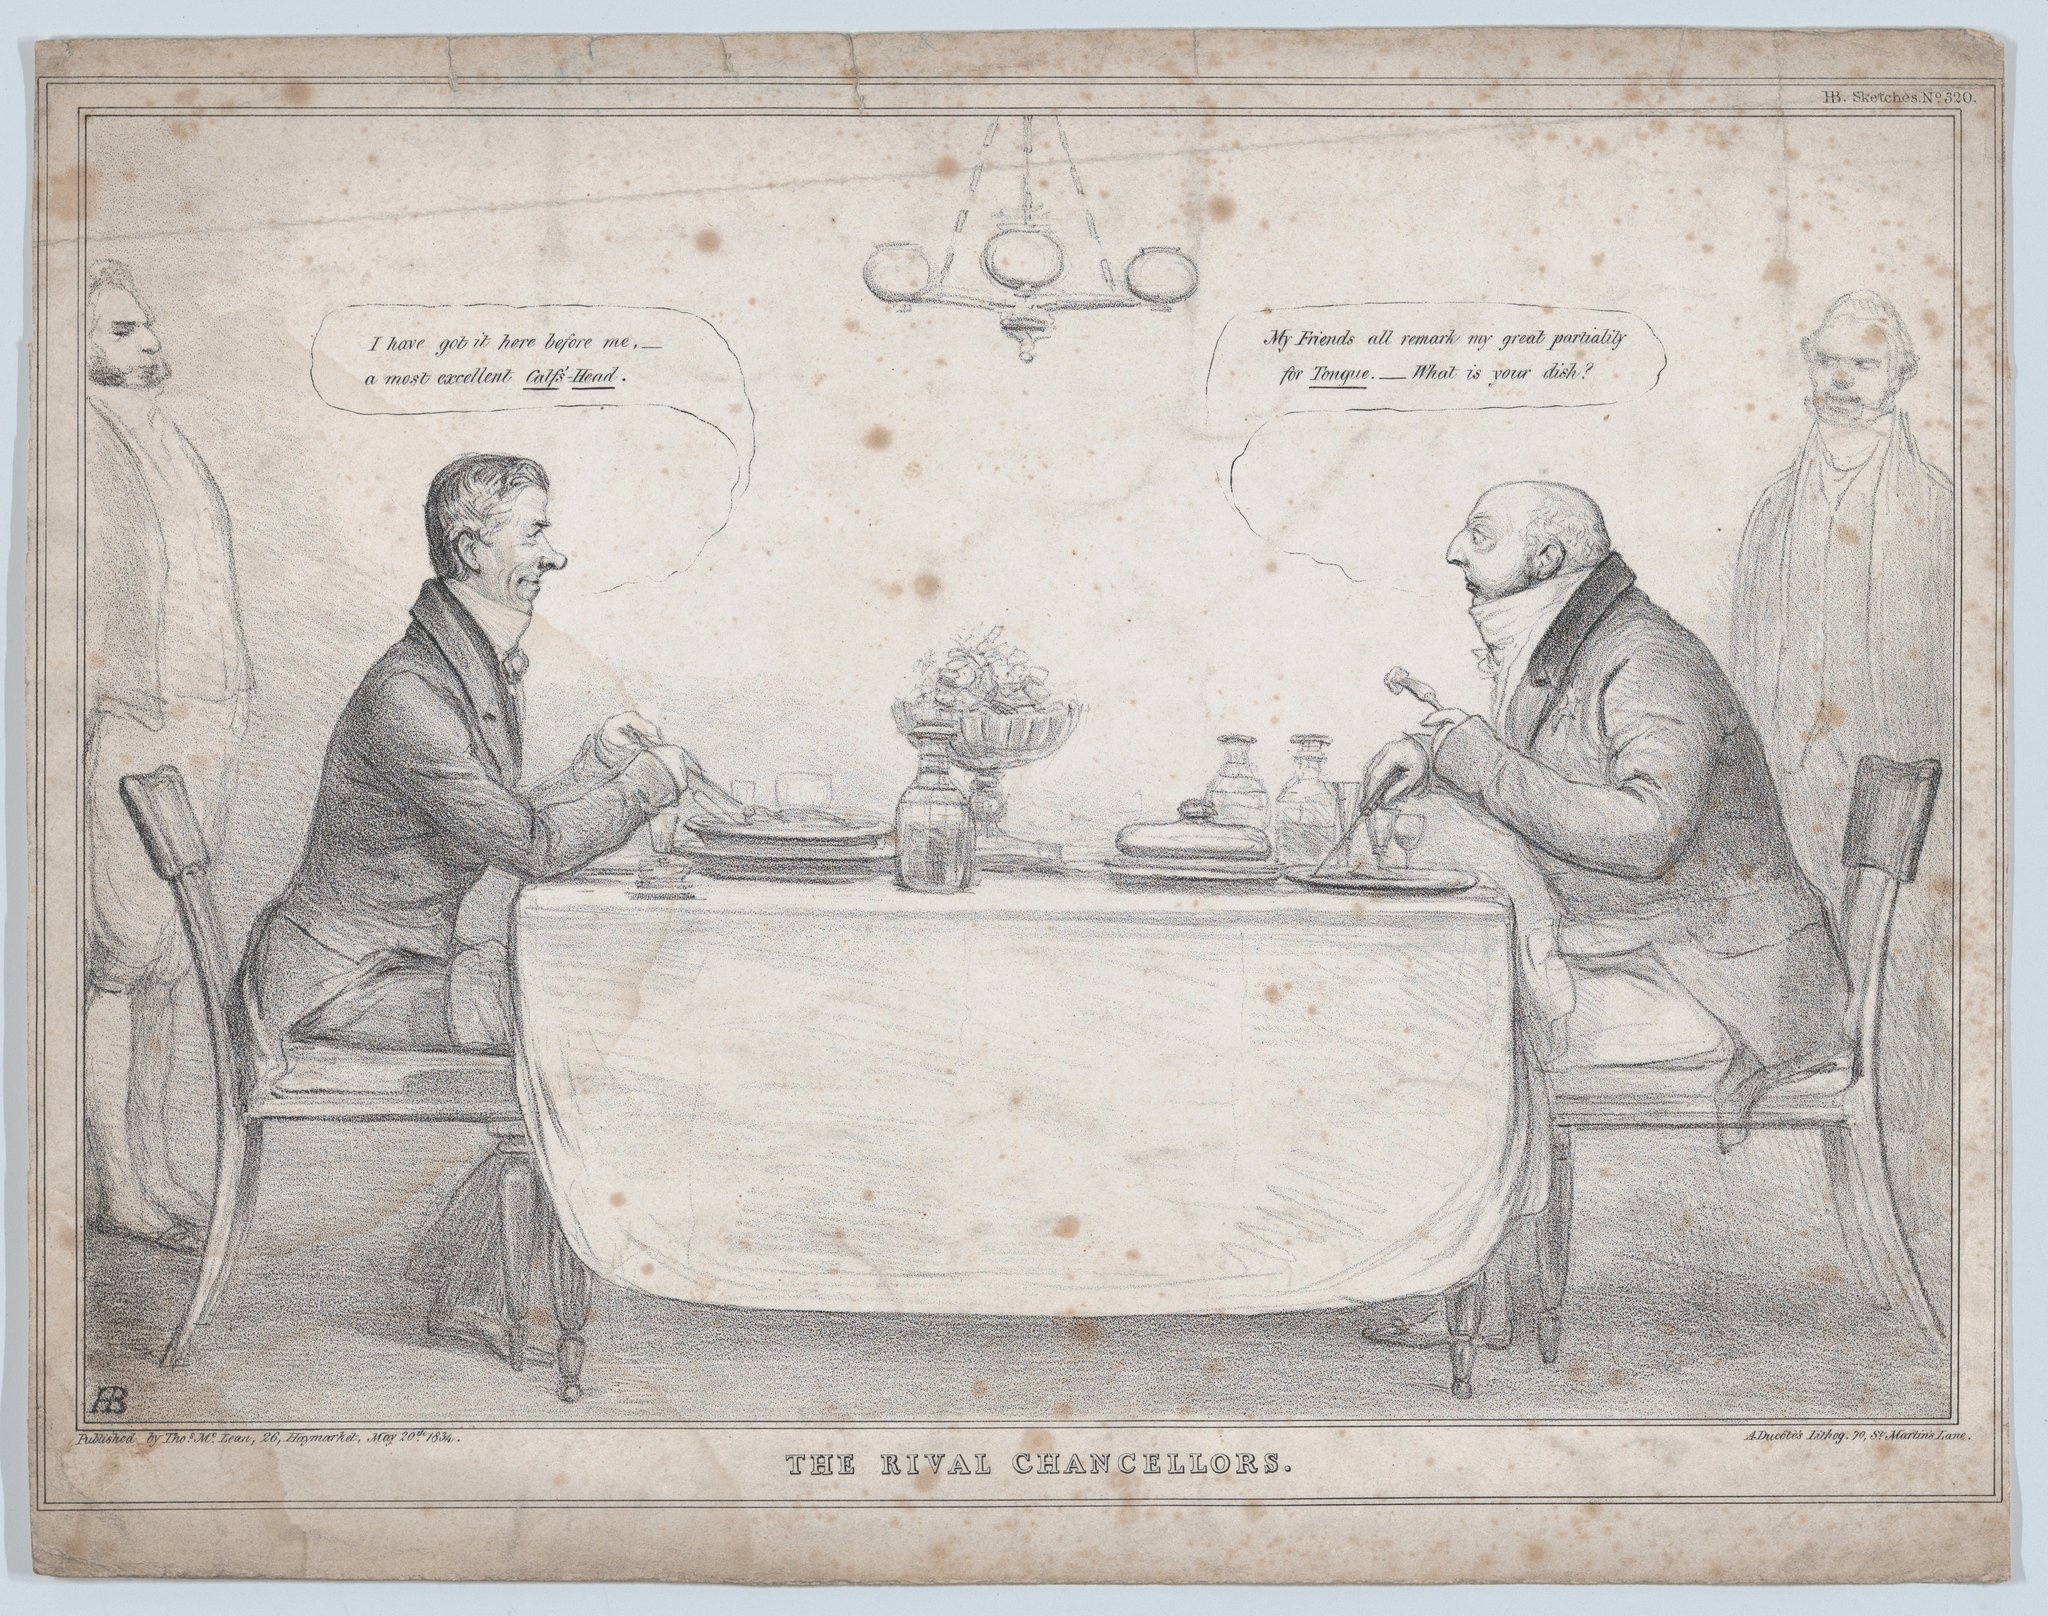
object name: print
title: The Rival Chancellors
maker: john doyle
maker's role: artist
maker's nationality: irish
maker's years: 1797-1868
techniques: lithograph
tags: satire,men,dining,politics